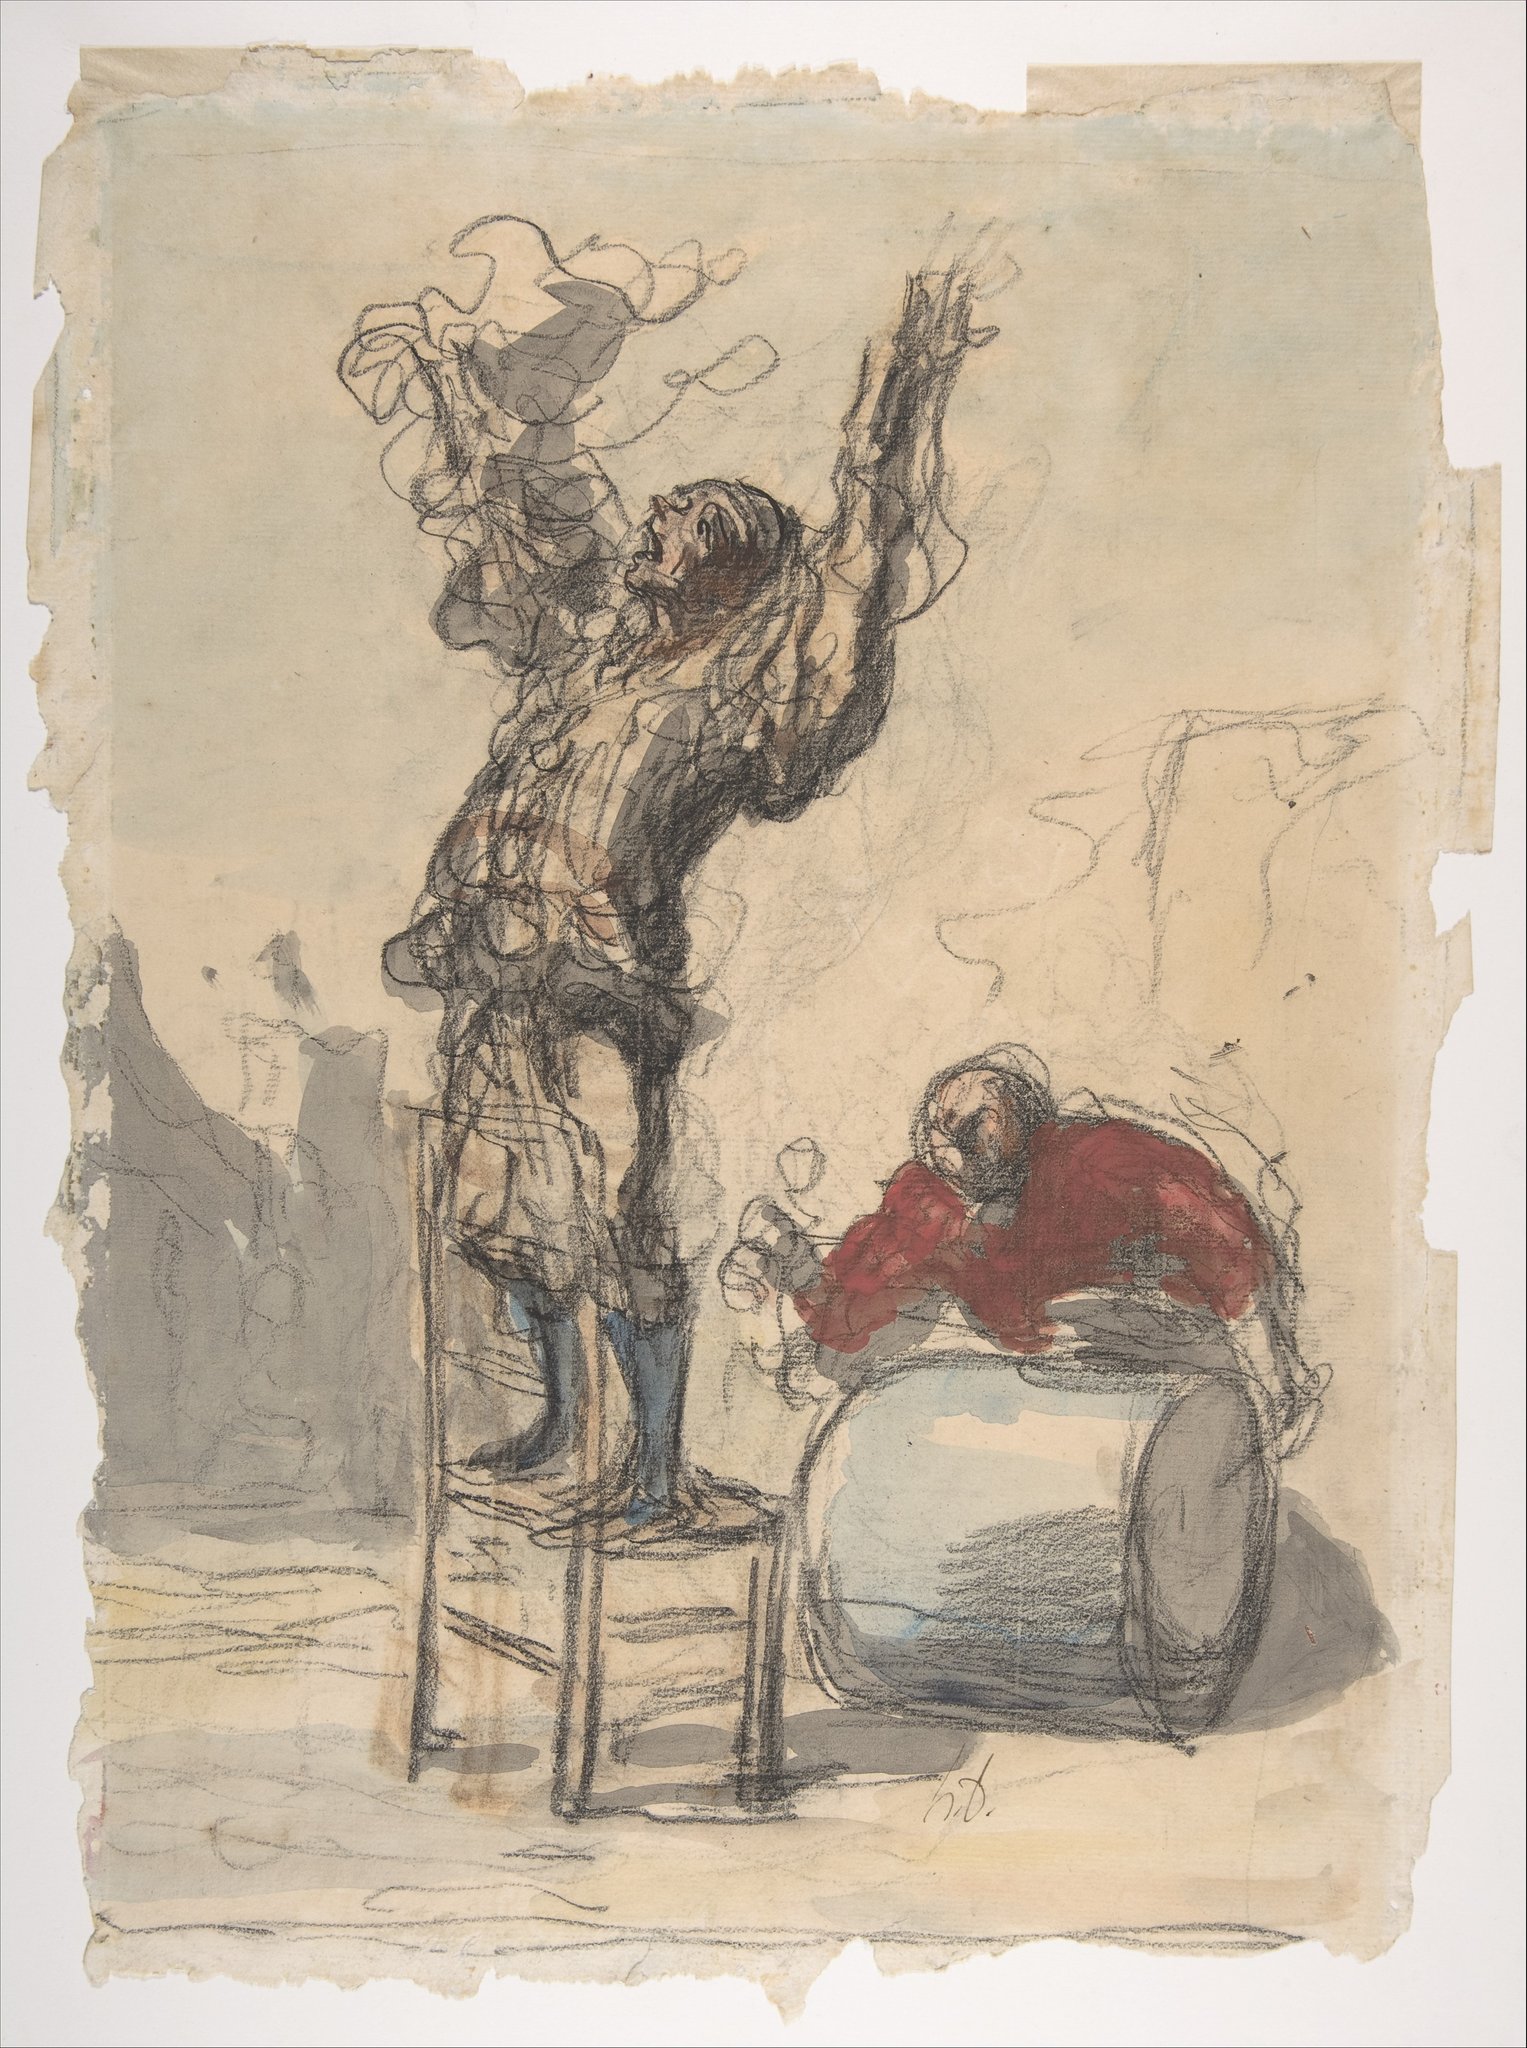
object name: drawing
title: Street Show (Paillasse) (recto); a clown playing a drum (verso)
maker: honoré daumier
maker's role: artist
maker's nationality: french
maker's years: 1808-1879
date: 1825-1879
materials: chalk, graphite, paper, watercolor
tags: men,drums,clowns,chairs